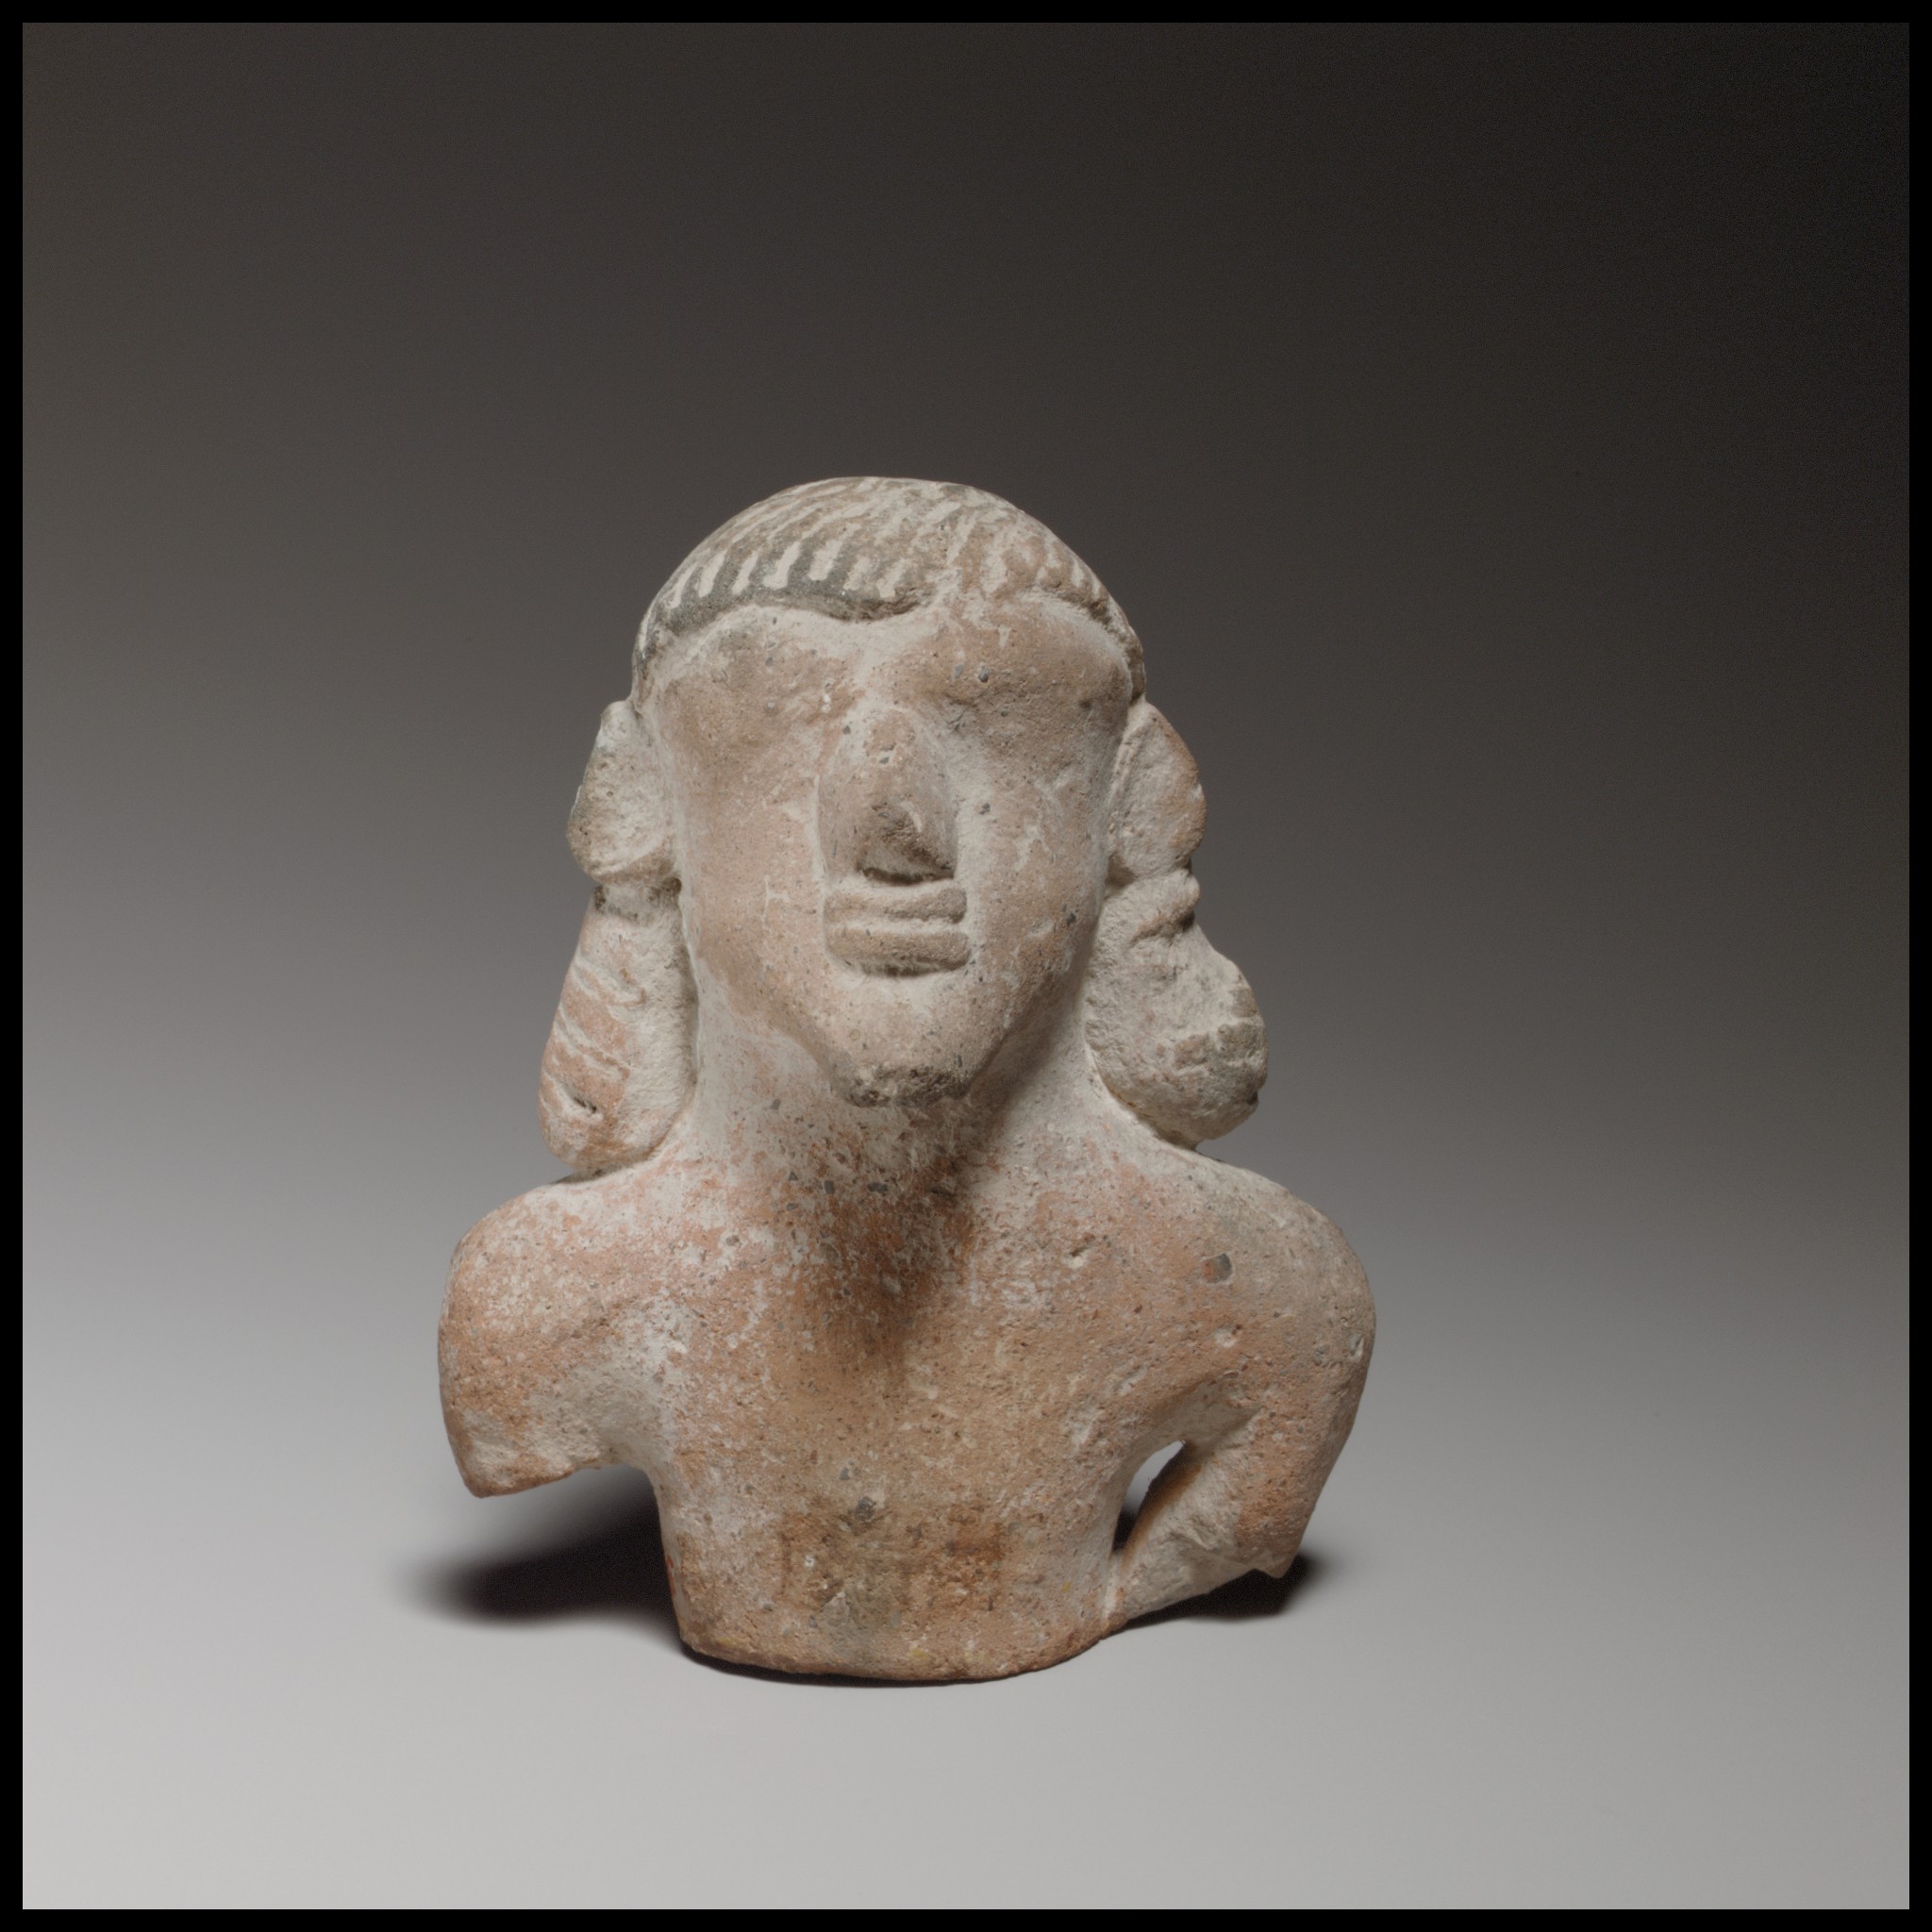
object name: head of a male votary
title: Male figurine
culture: cypriot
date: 600-480 BCE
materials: terracotta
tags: men